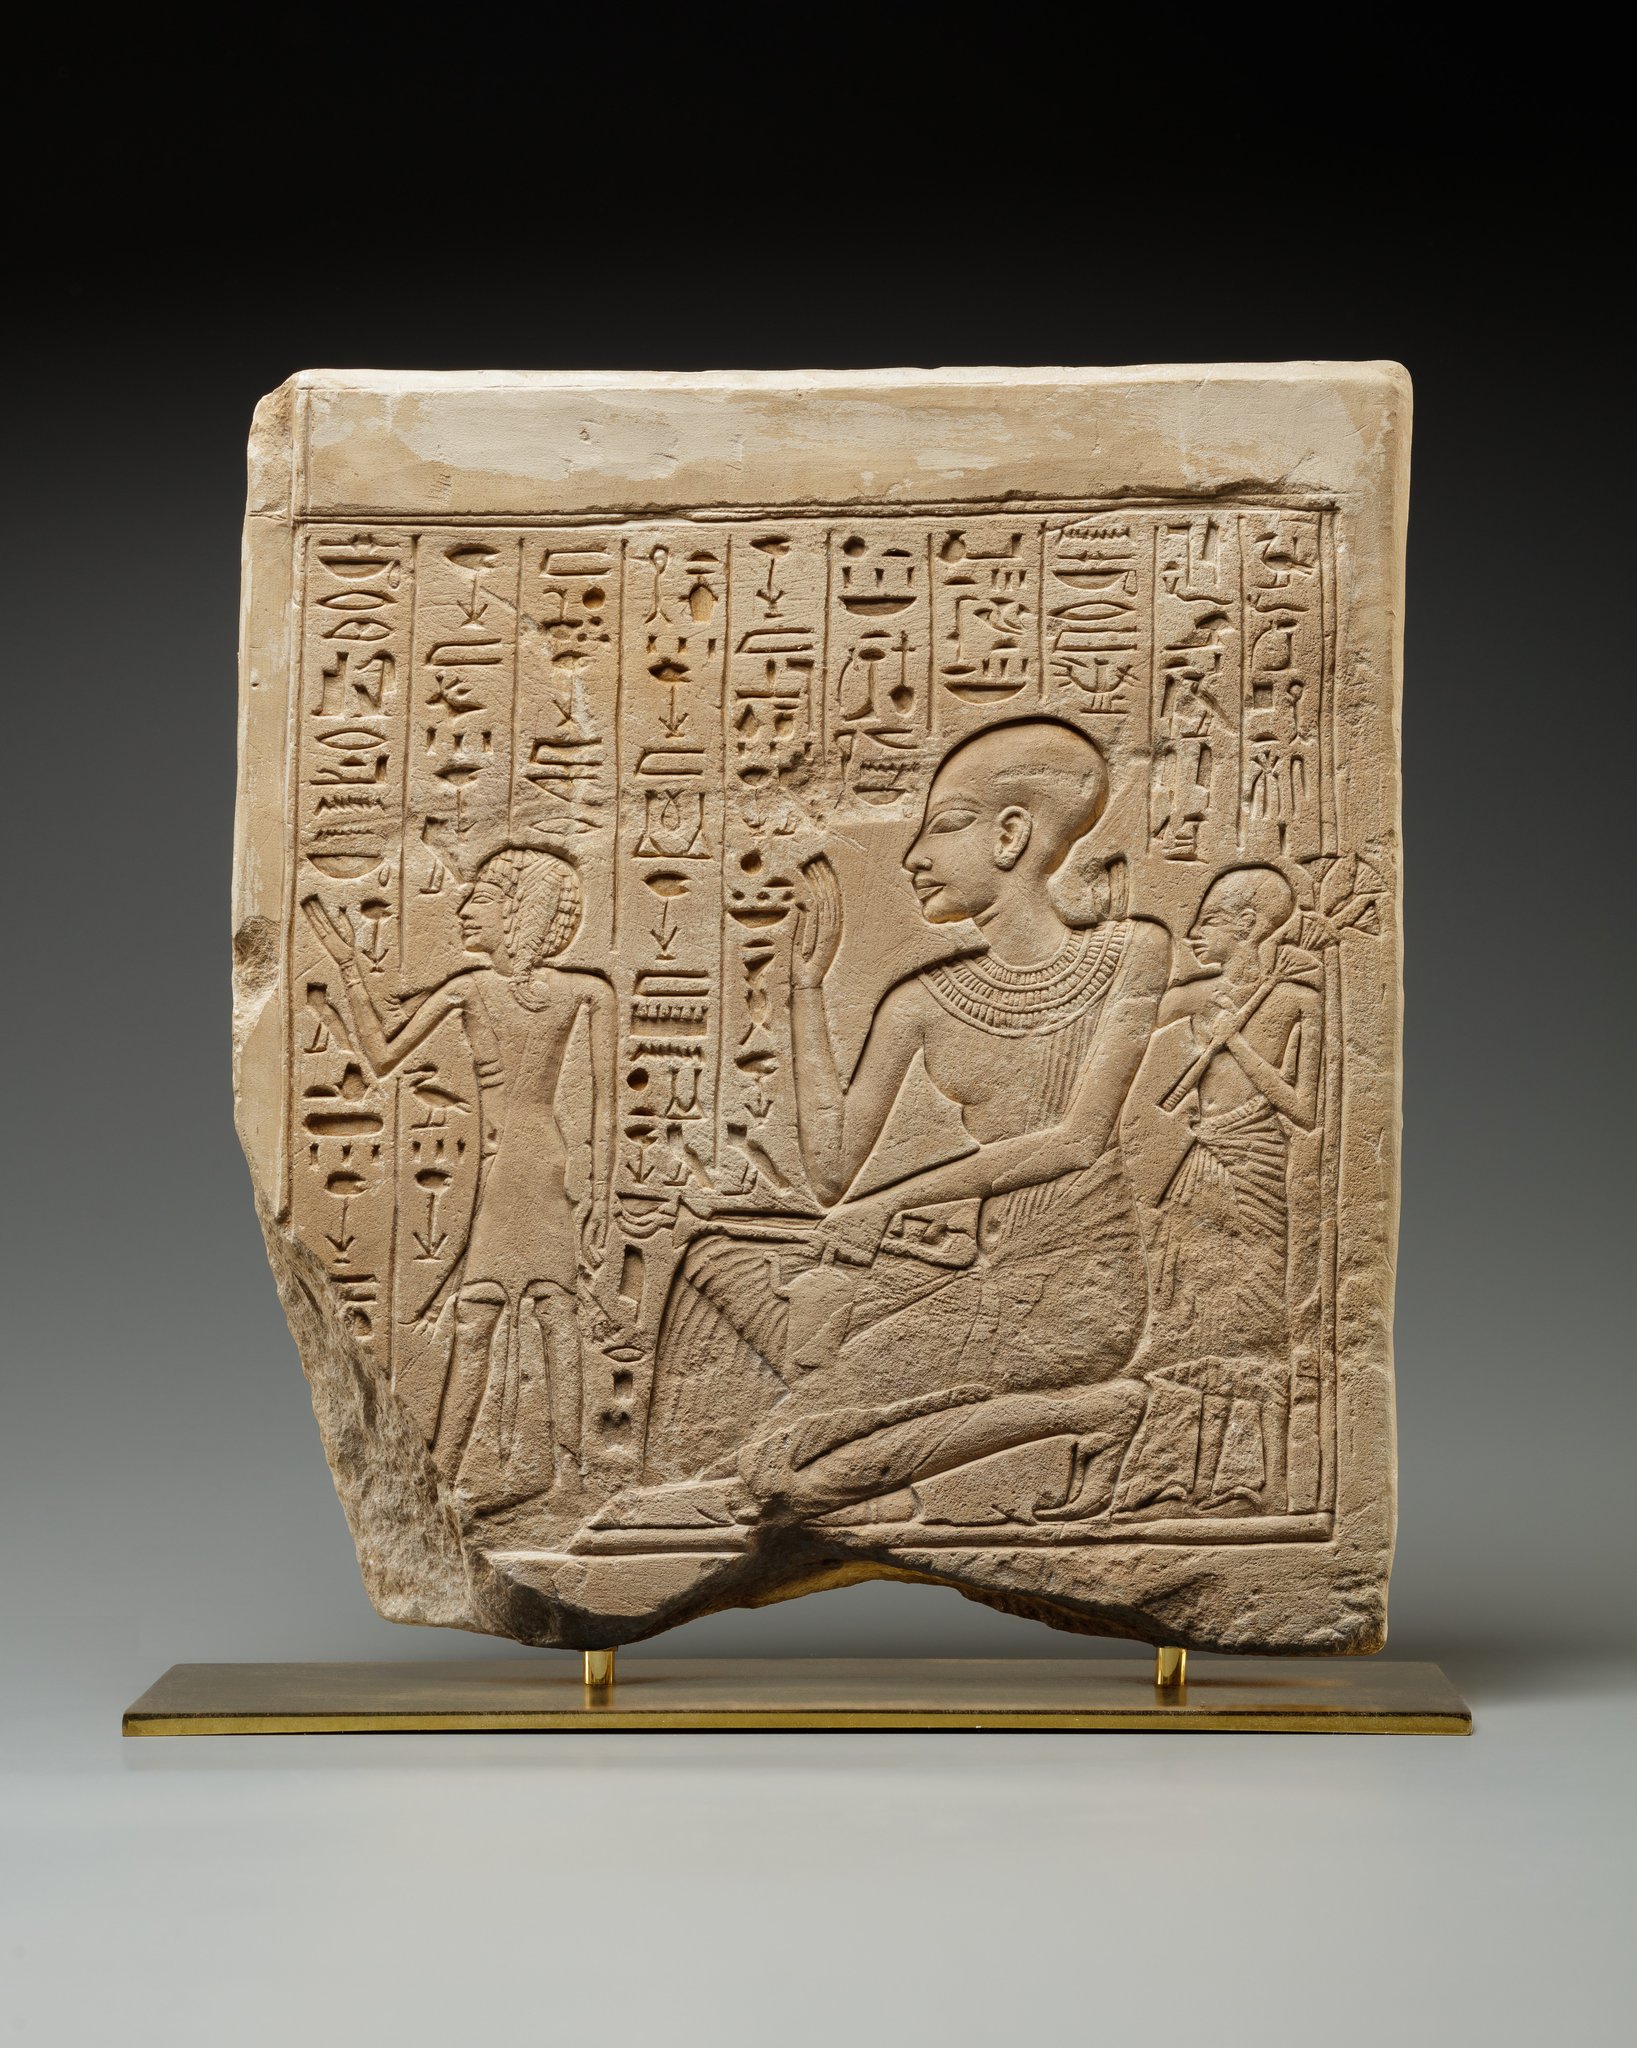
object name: stela, hatiay, saqqara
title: Relief of Hatiay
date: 1336-1295 BCE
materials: limestone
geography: egypt